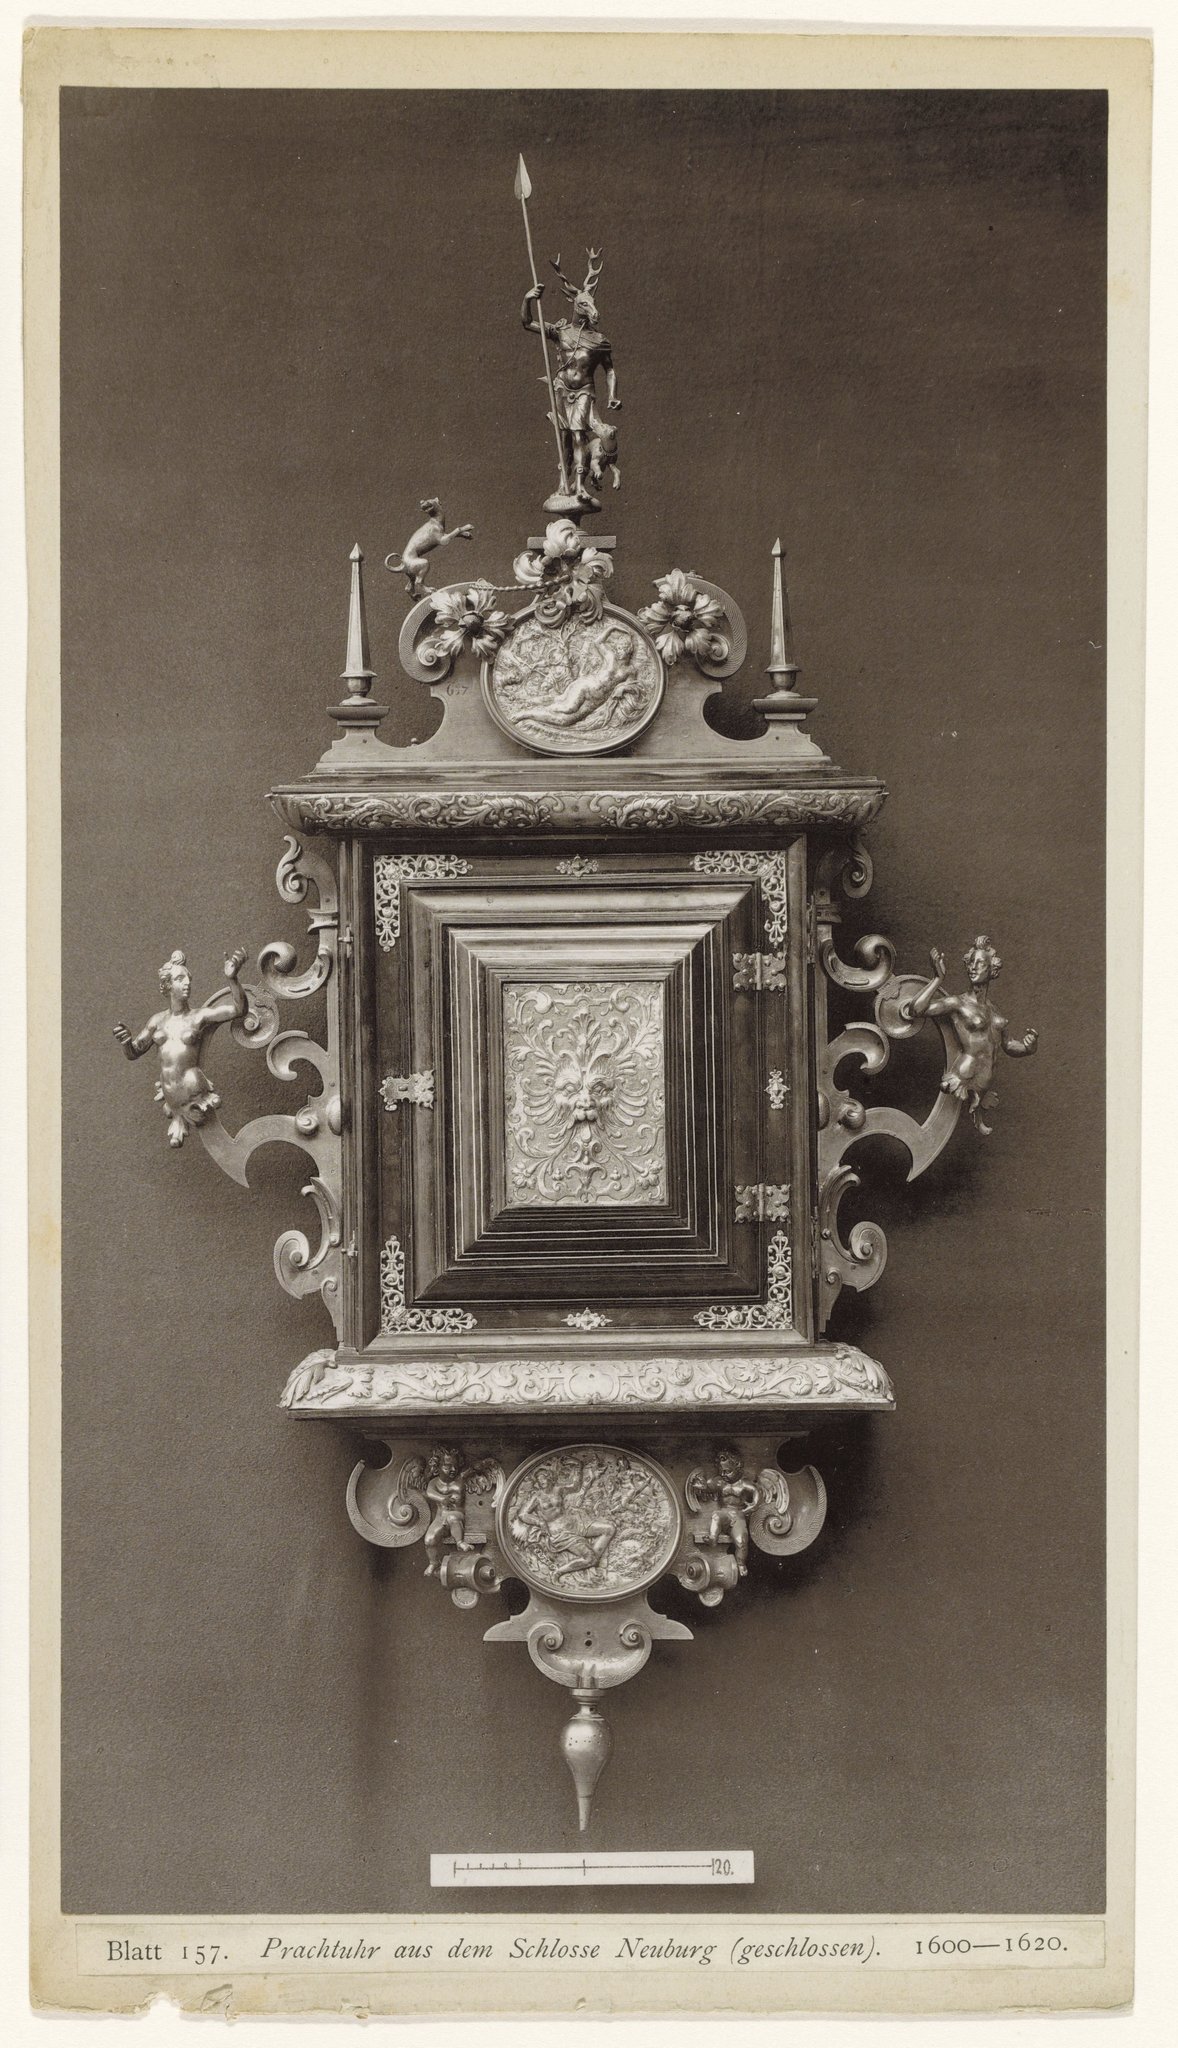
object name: photomechanical print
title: Prachtuhr aus dem Schlosse Neuburg (geschlossen). 1600-1620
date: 1876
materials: cardboard, paper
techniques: photograph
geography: neuburg an der donau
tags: clock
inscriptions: title: ‘Blatt 157. Prachtuhr aus dem Schlosse Neuburg (geschlossen). 1600-1620.’